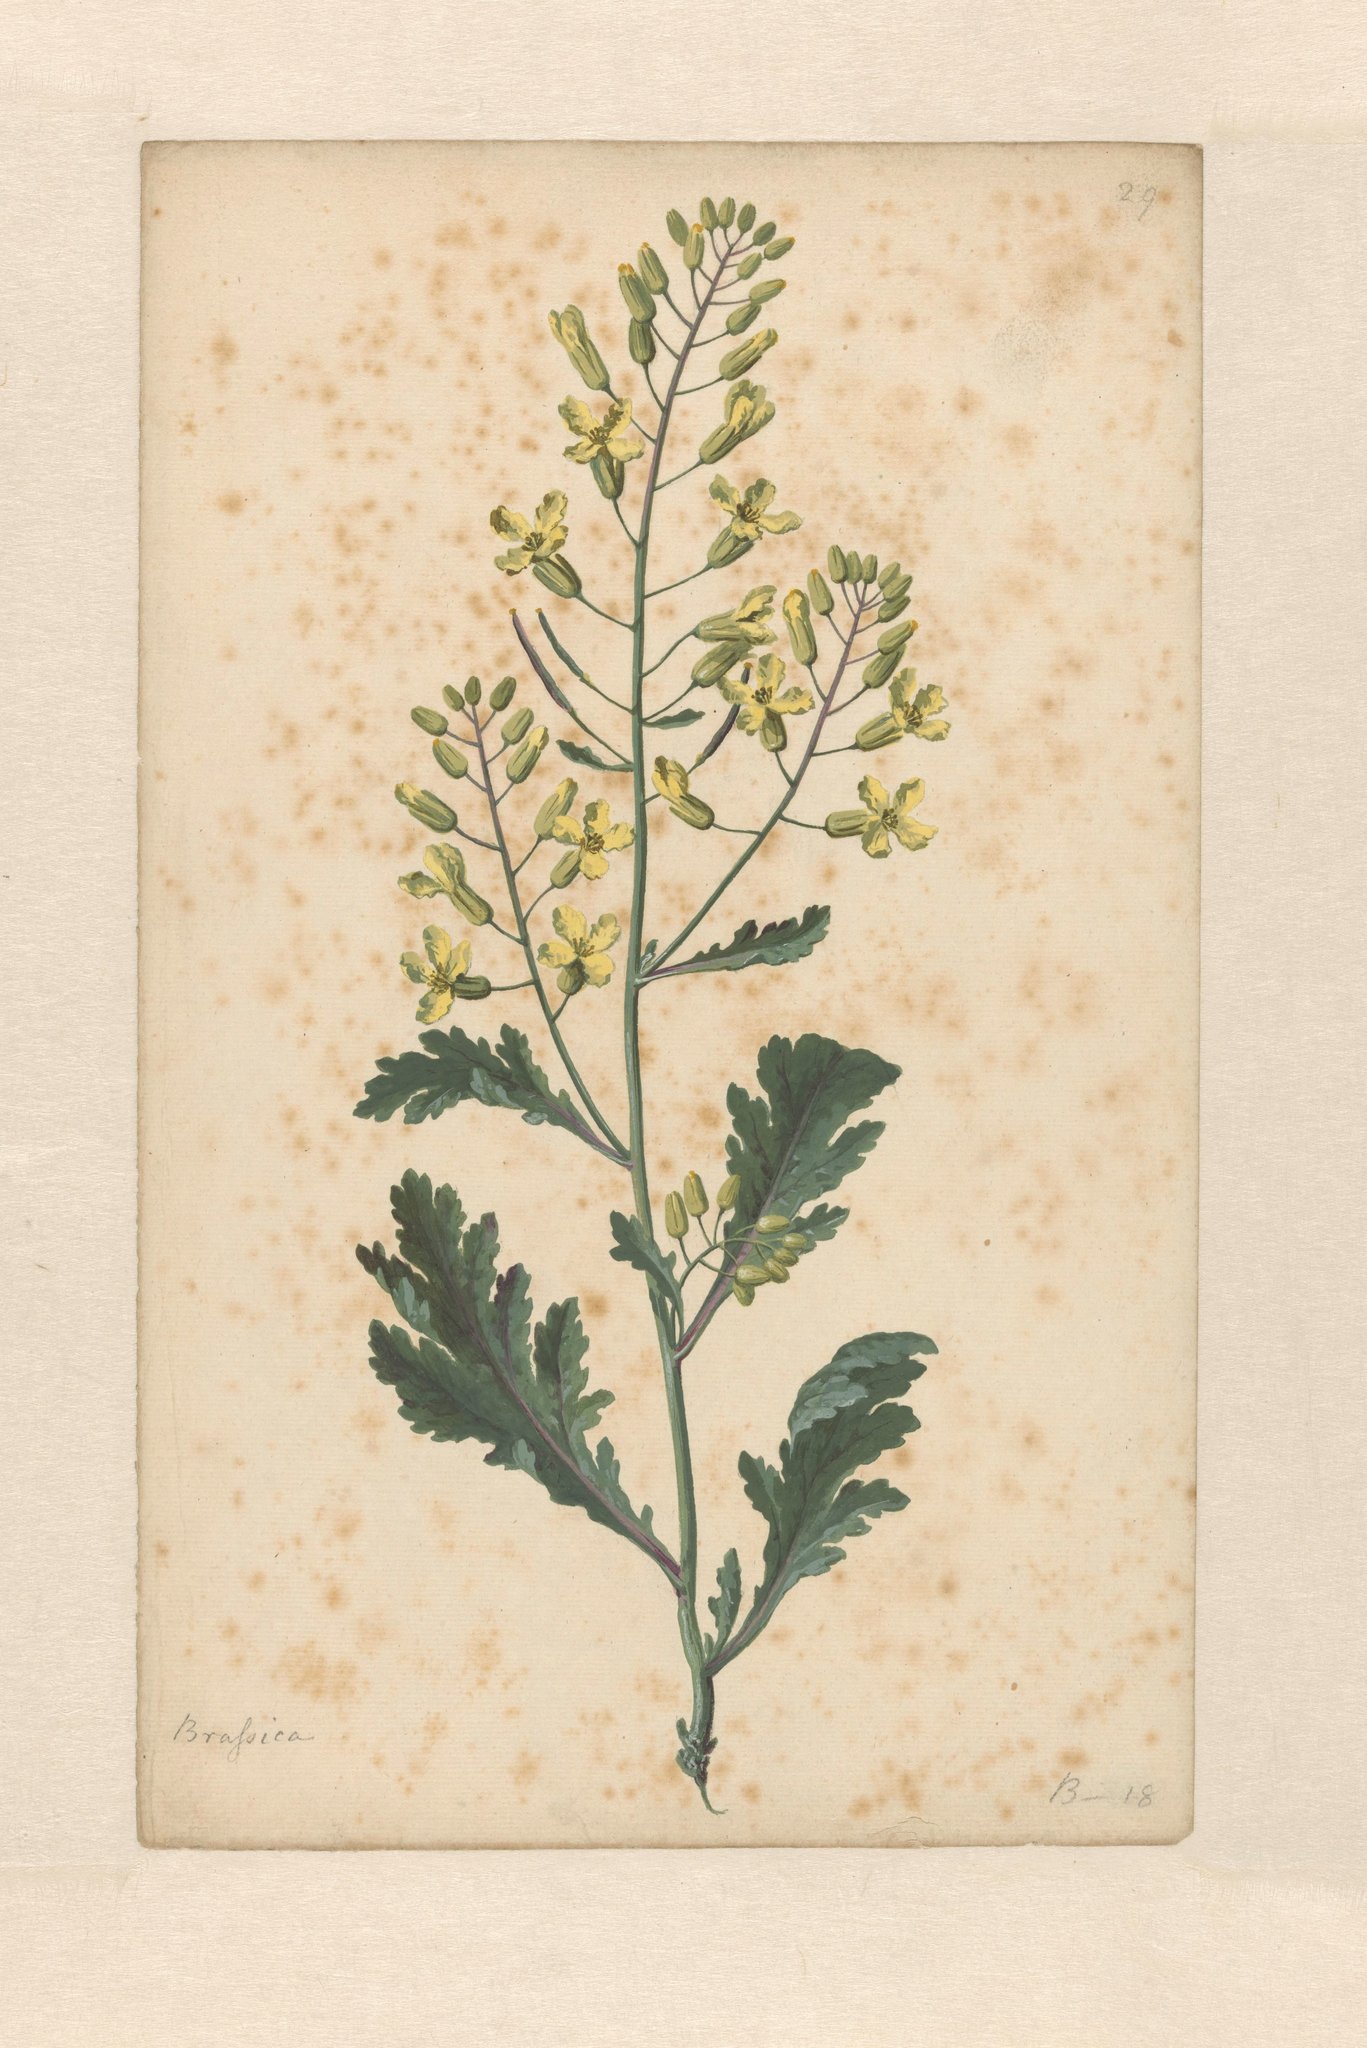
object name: drawing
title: Black Mustard (Brassica nigra)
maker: alida withoos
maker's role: draughtsman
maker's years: 1659-1730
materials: paint, paper, pencil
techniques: brush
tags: flowers: brassica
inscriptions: collector's mark: Lugt 646a, number: ‘2026’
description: Rechts boven genummerd 29, rechts onder genummerd B-18.